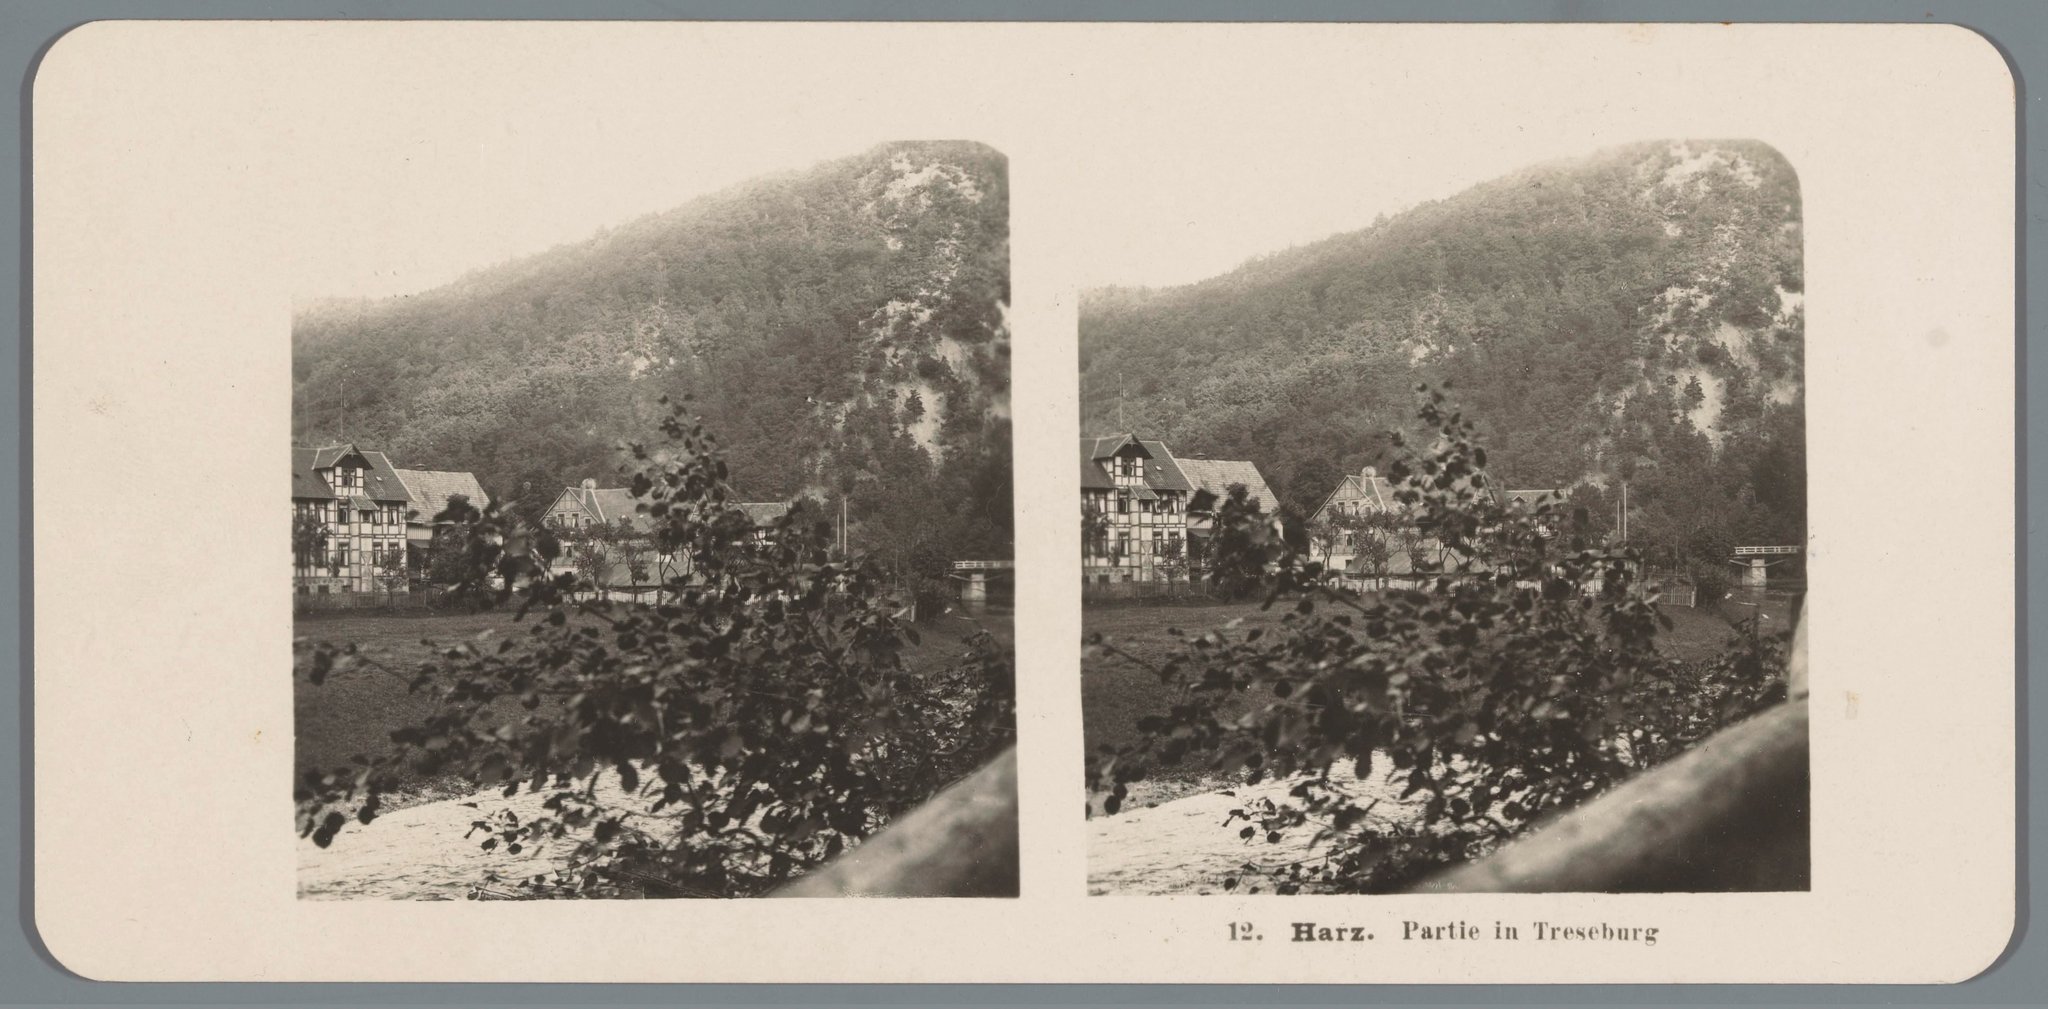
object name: stereograph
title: Gezicht op Treseburg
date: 1904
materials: cardboard, photographic support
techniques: gelatin silver print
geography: harz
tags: river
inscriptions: number: ‘12.’, inscription: ‘Neue Photographische Gesellschaft A.-G., Steglitz-Berlin 1904.’